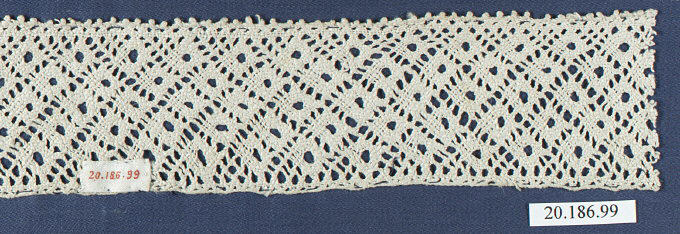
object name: strip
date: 1501-1700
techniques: lace